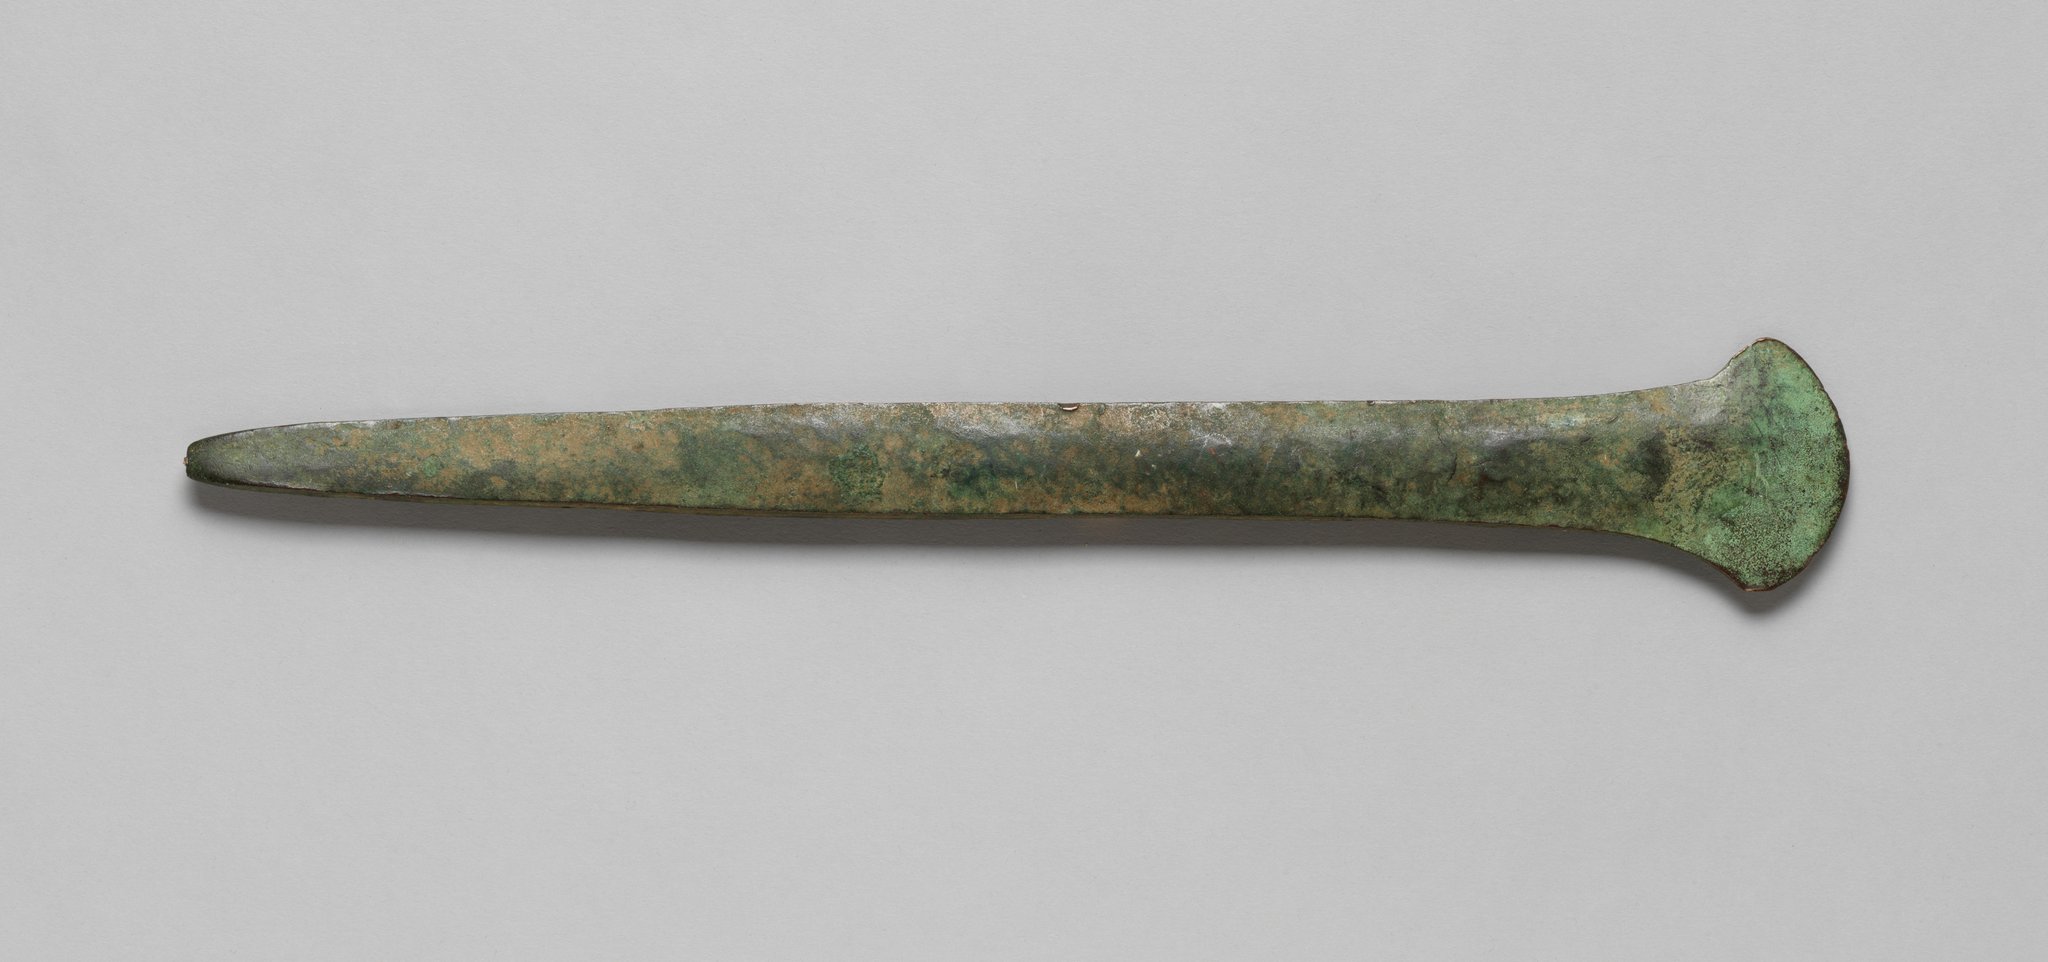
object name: tool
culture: indian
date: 1500-1000 BCE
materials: copper